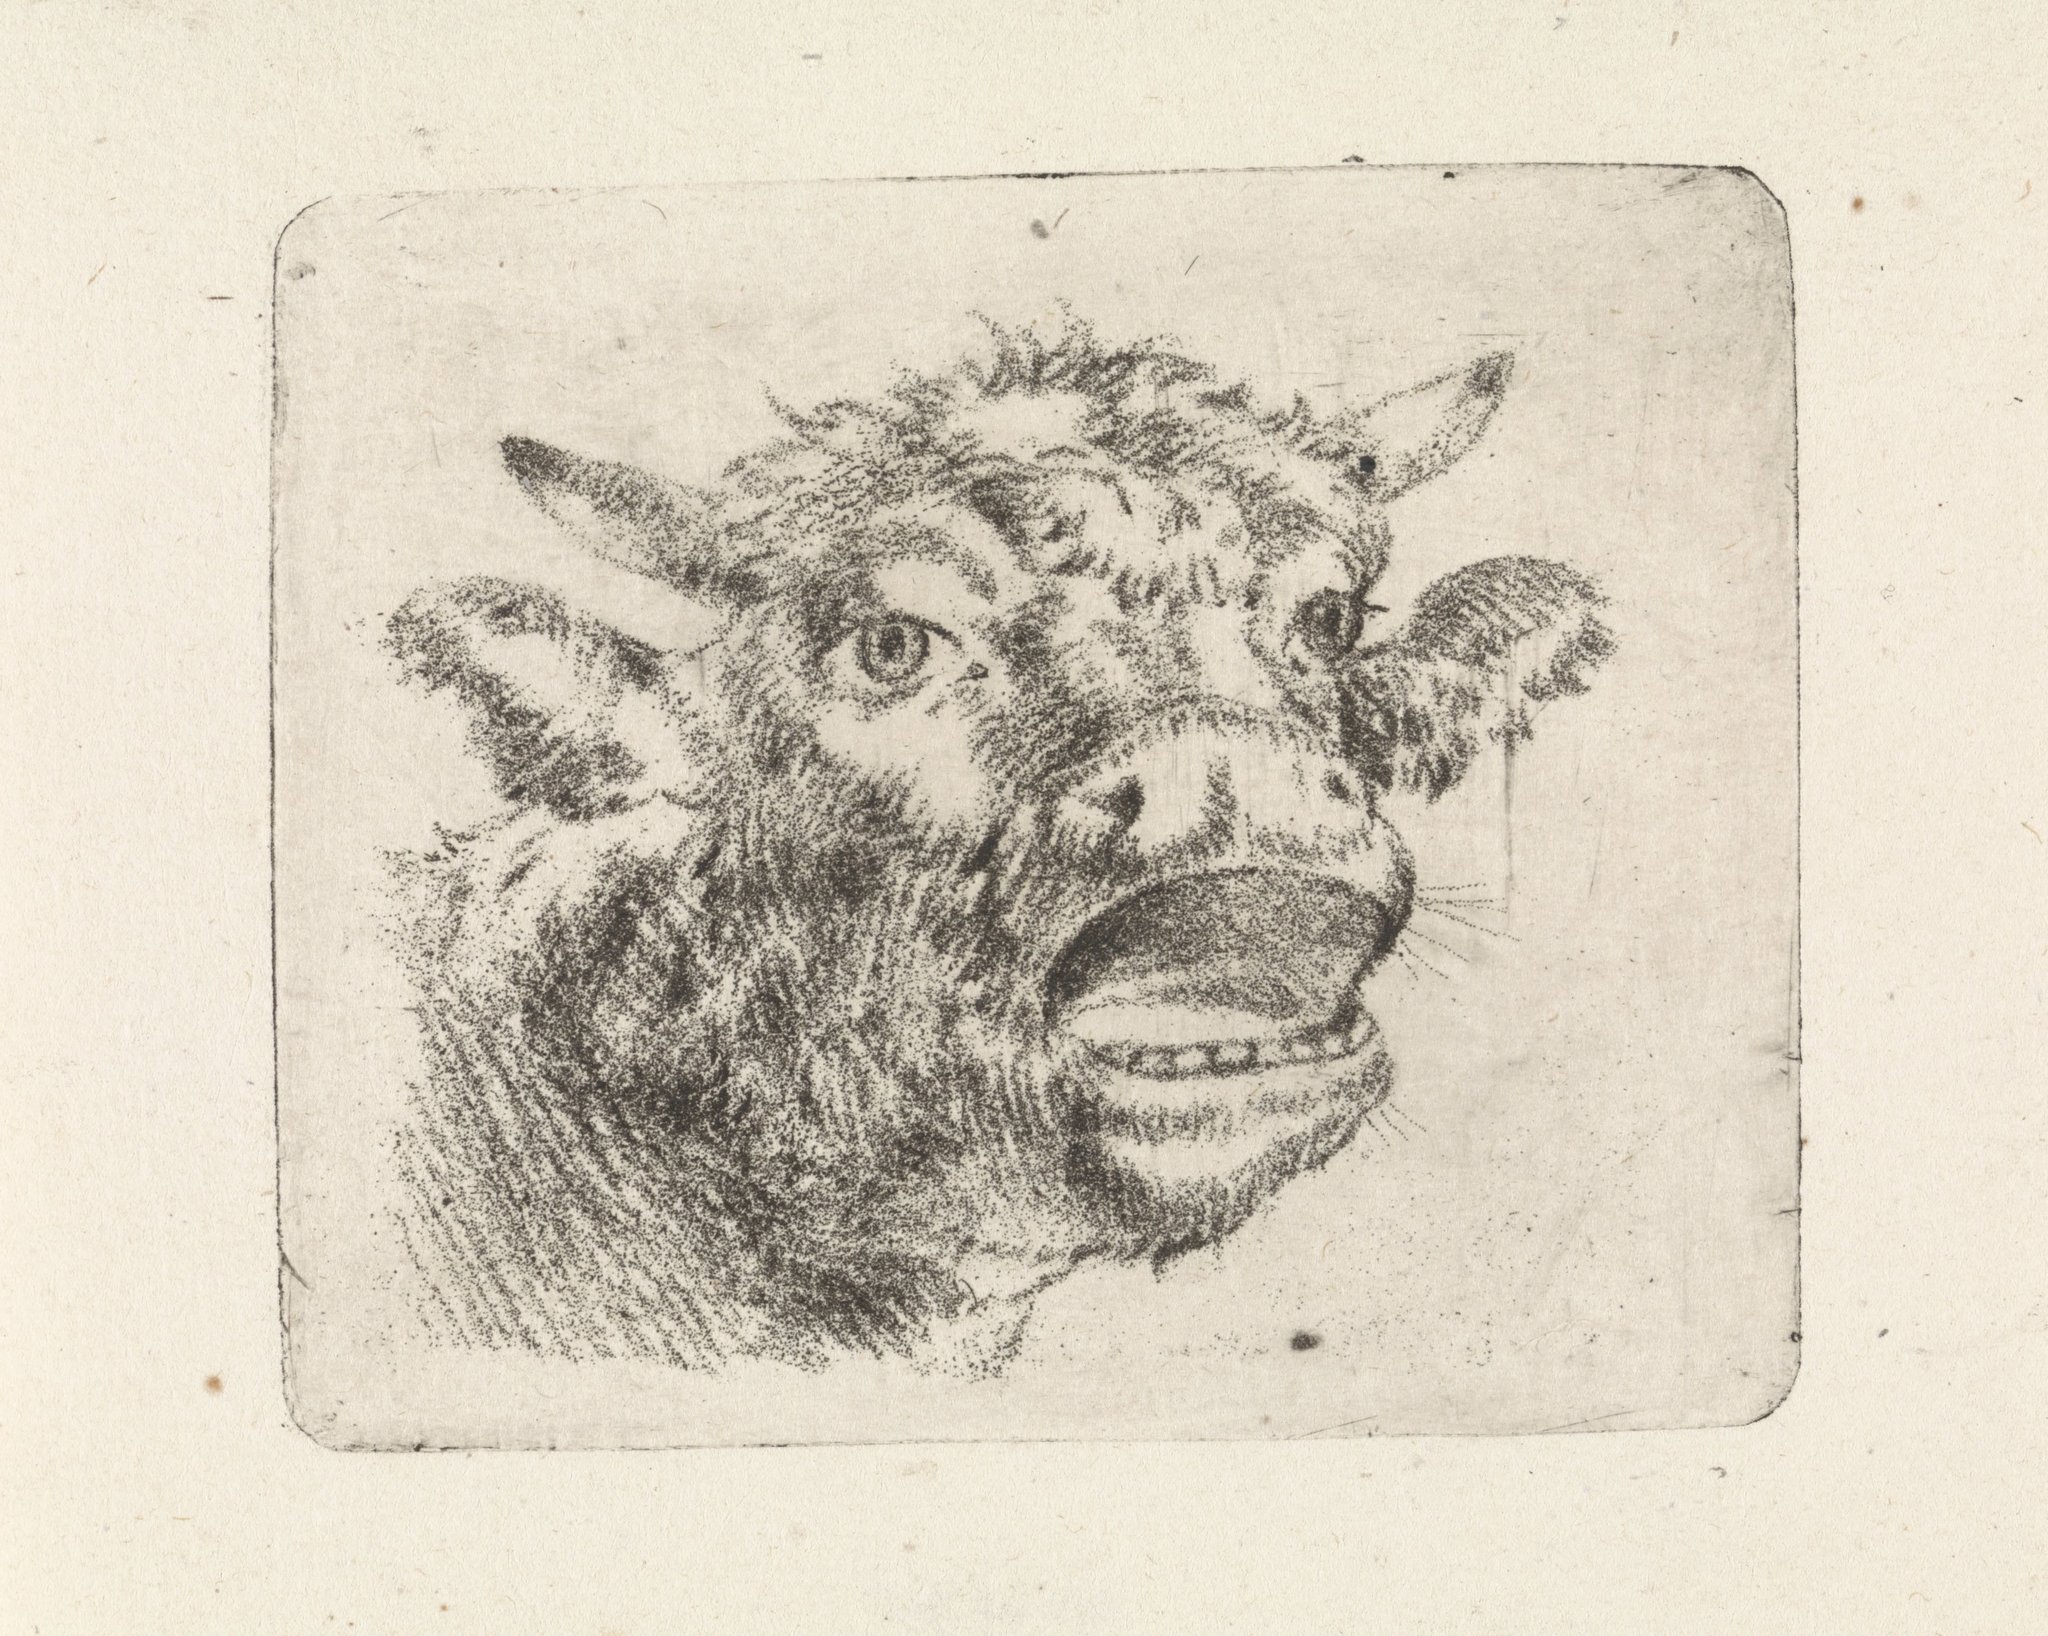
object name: print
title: Koeienkop, loeiend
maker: pieter janson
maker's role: draughtsman, print maker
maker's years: 1765-1851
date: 1780-1851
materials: paper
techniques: soft ground etching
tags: cow